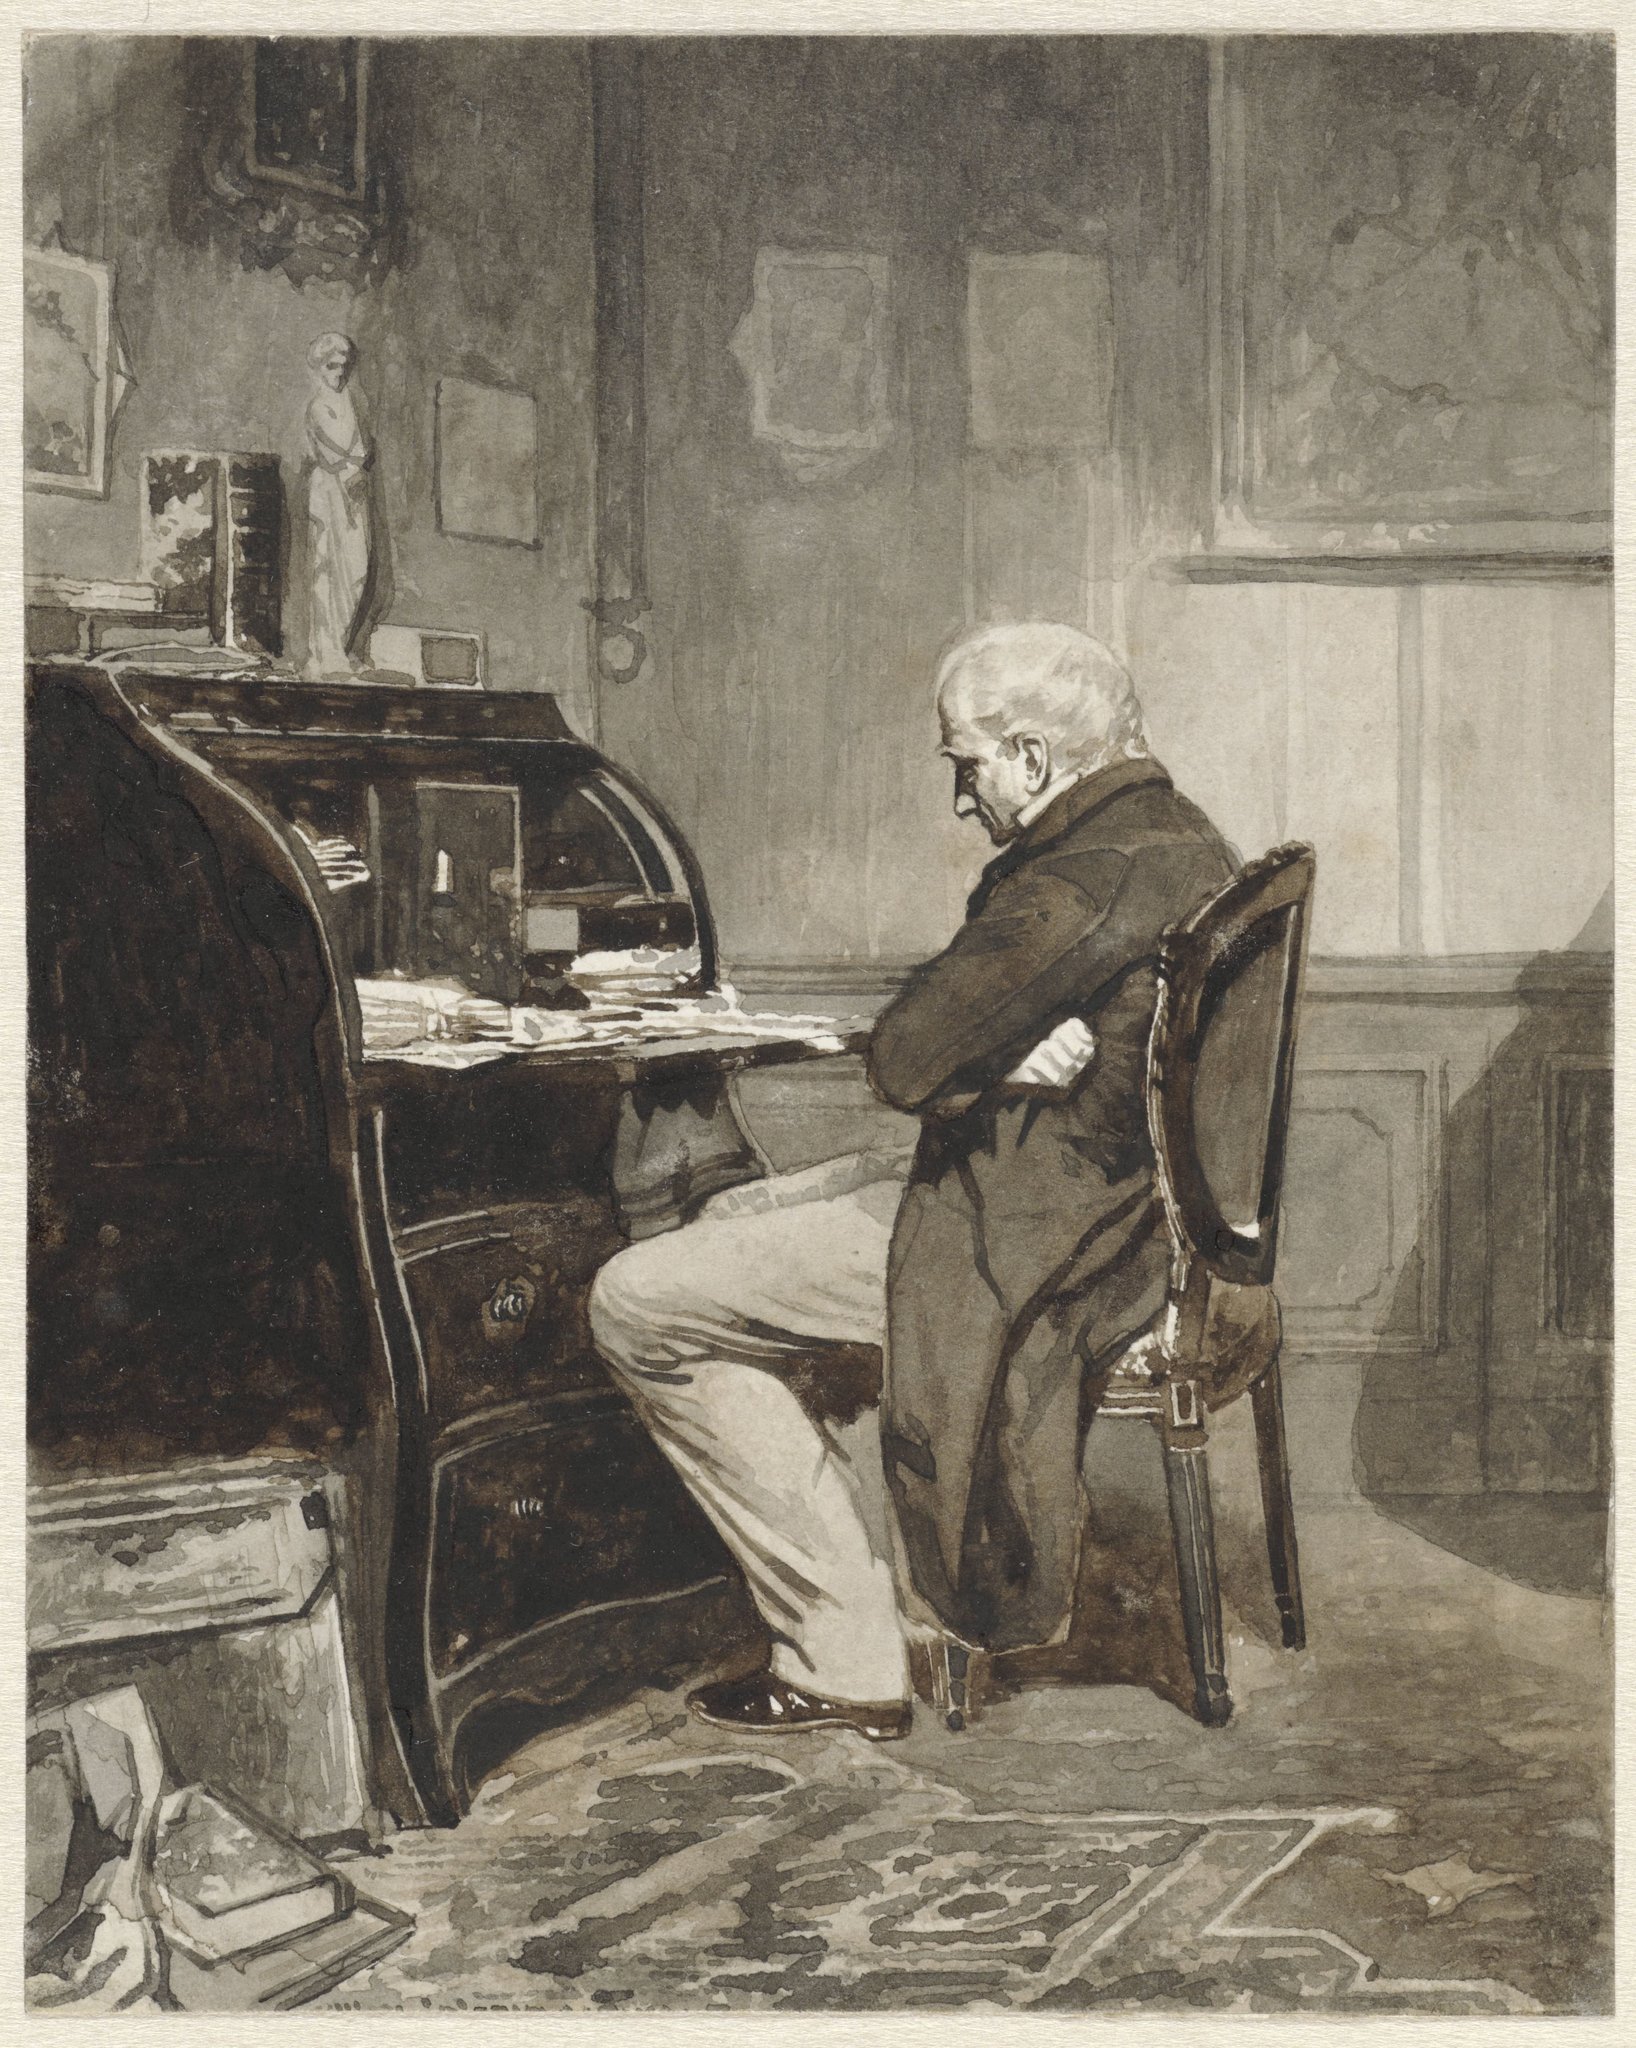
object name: drawing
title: Een slechte beursdag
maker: diederik franciscus jamin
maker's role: draughtsman, painter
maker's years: 1838-1865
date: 1848-1865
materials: ink, paper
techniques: brush, pen